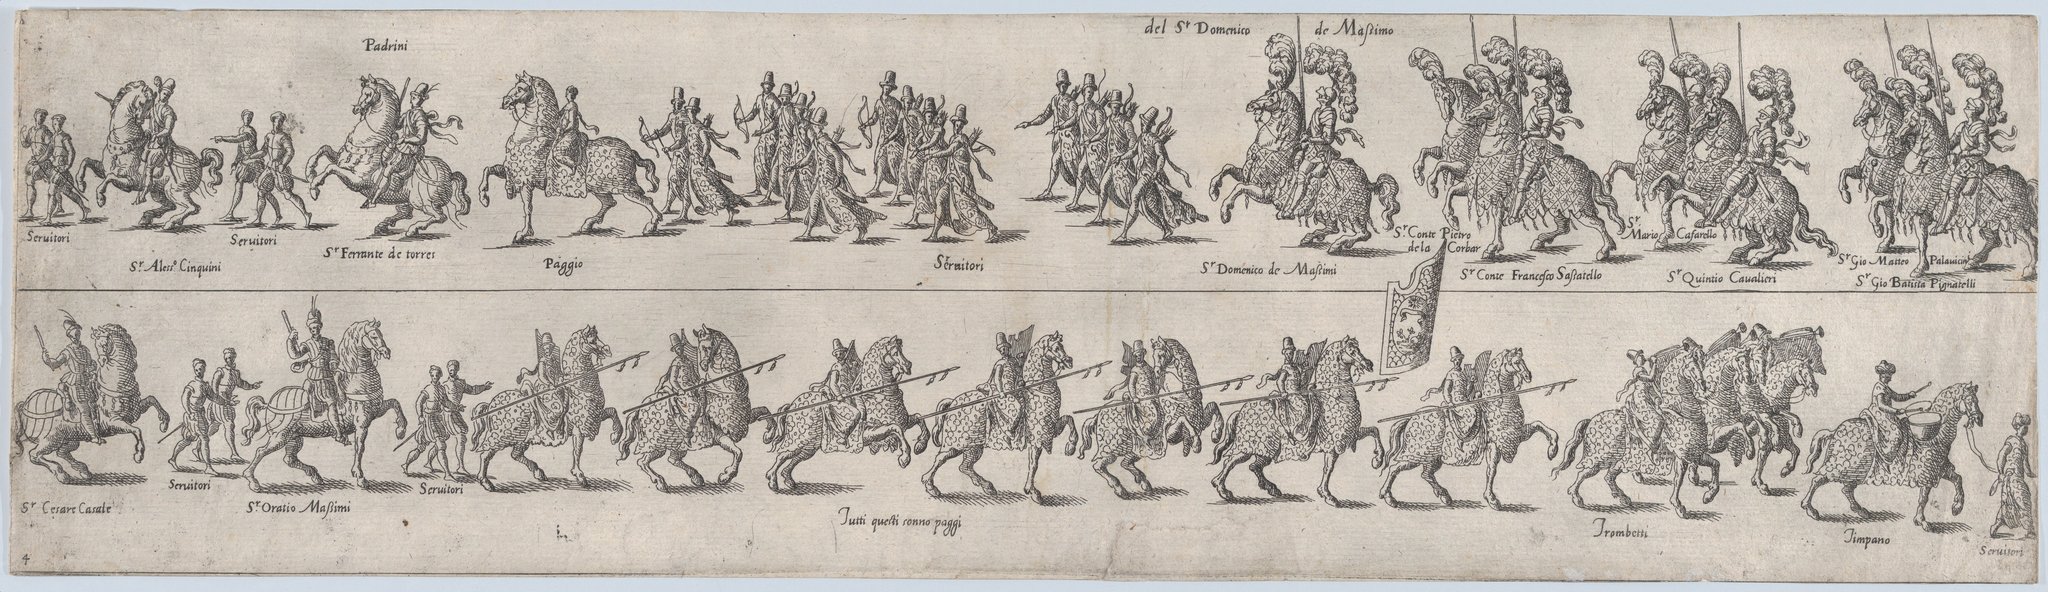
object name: print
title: Plate depicting Domenico de Massimo, from a series of twelve showing knights and their attendants dressed for a tournament (plate 4)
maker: Anonymous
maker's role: artist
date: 1565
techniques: etching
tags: men,horses,knights